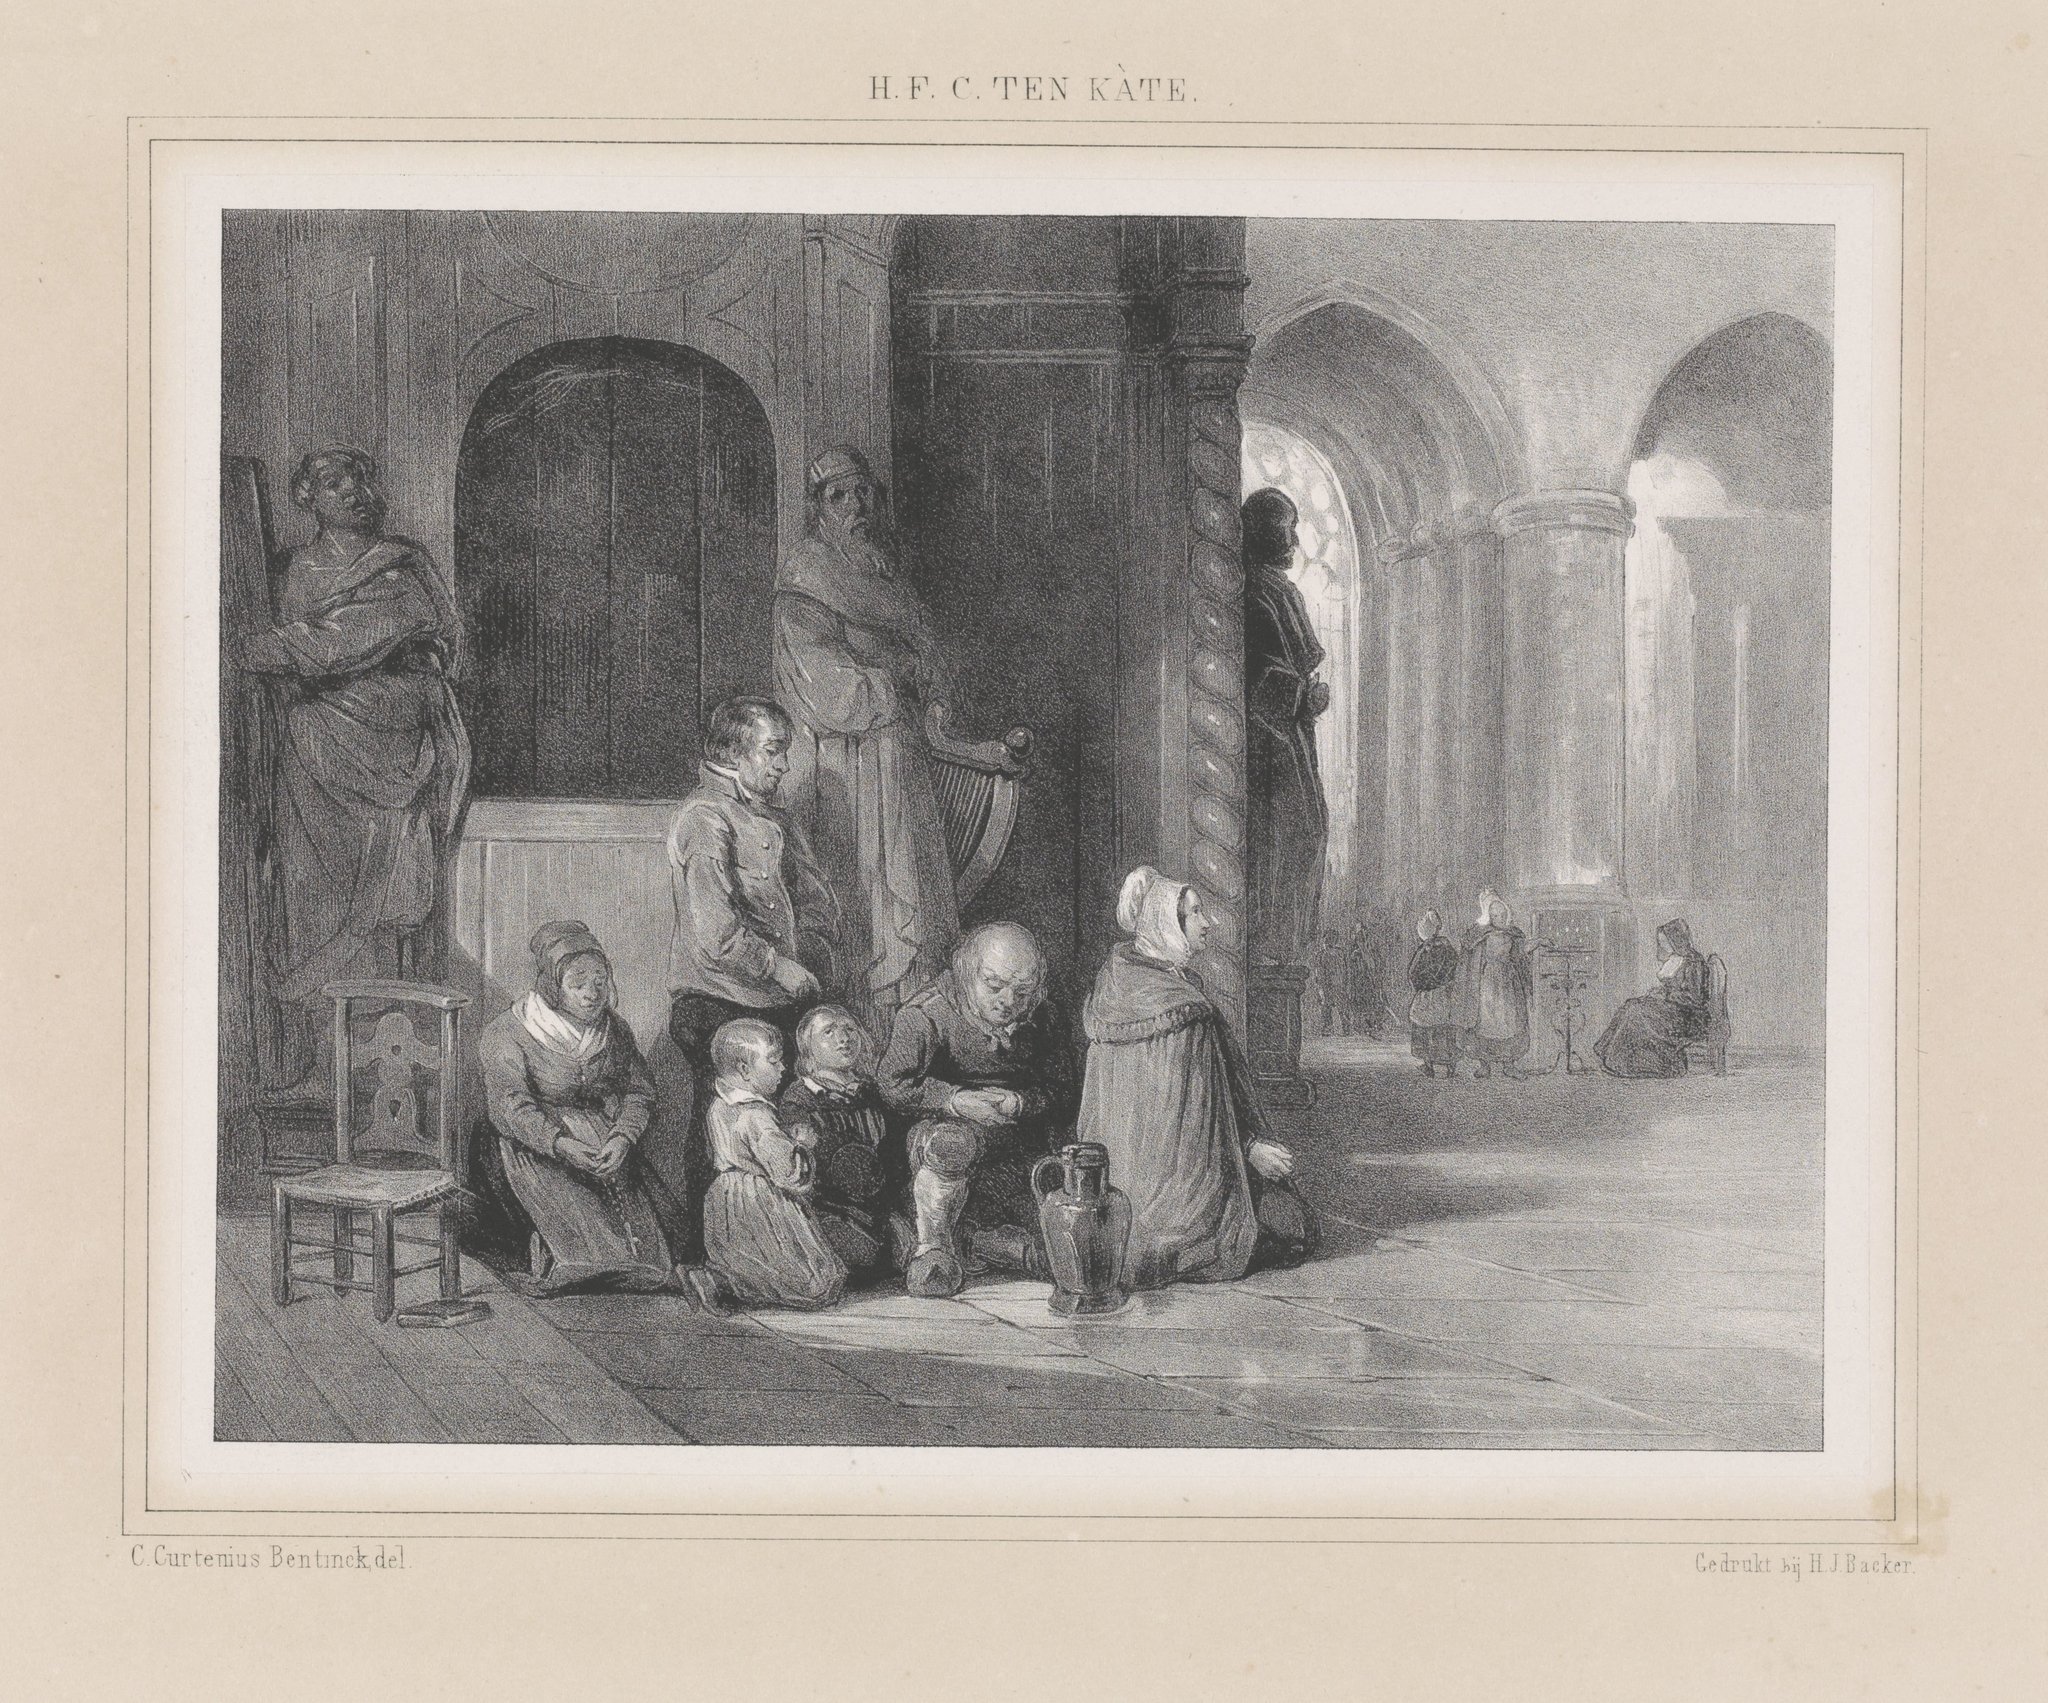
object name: print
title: Gezin in gebed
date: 1822-1845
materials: paper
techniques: lithograph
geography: the hague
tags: armchair, seat, interior of church, private worship and religious study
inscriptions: collector's mark: Lugt 2228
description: De vier volwassenen en twee kinderen zitten en staan in een kerkinterieur. Zij kijken allemaal naar rechts en zijn in gebed. Achter hen sculpturen van heiligen en een lege stoel. Naar een schilderij van Herman Frederik Carel ten Kate.